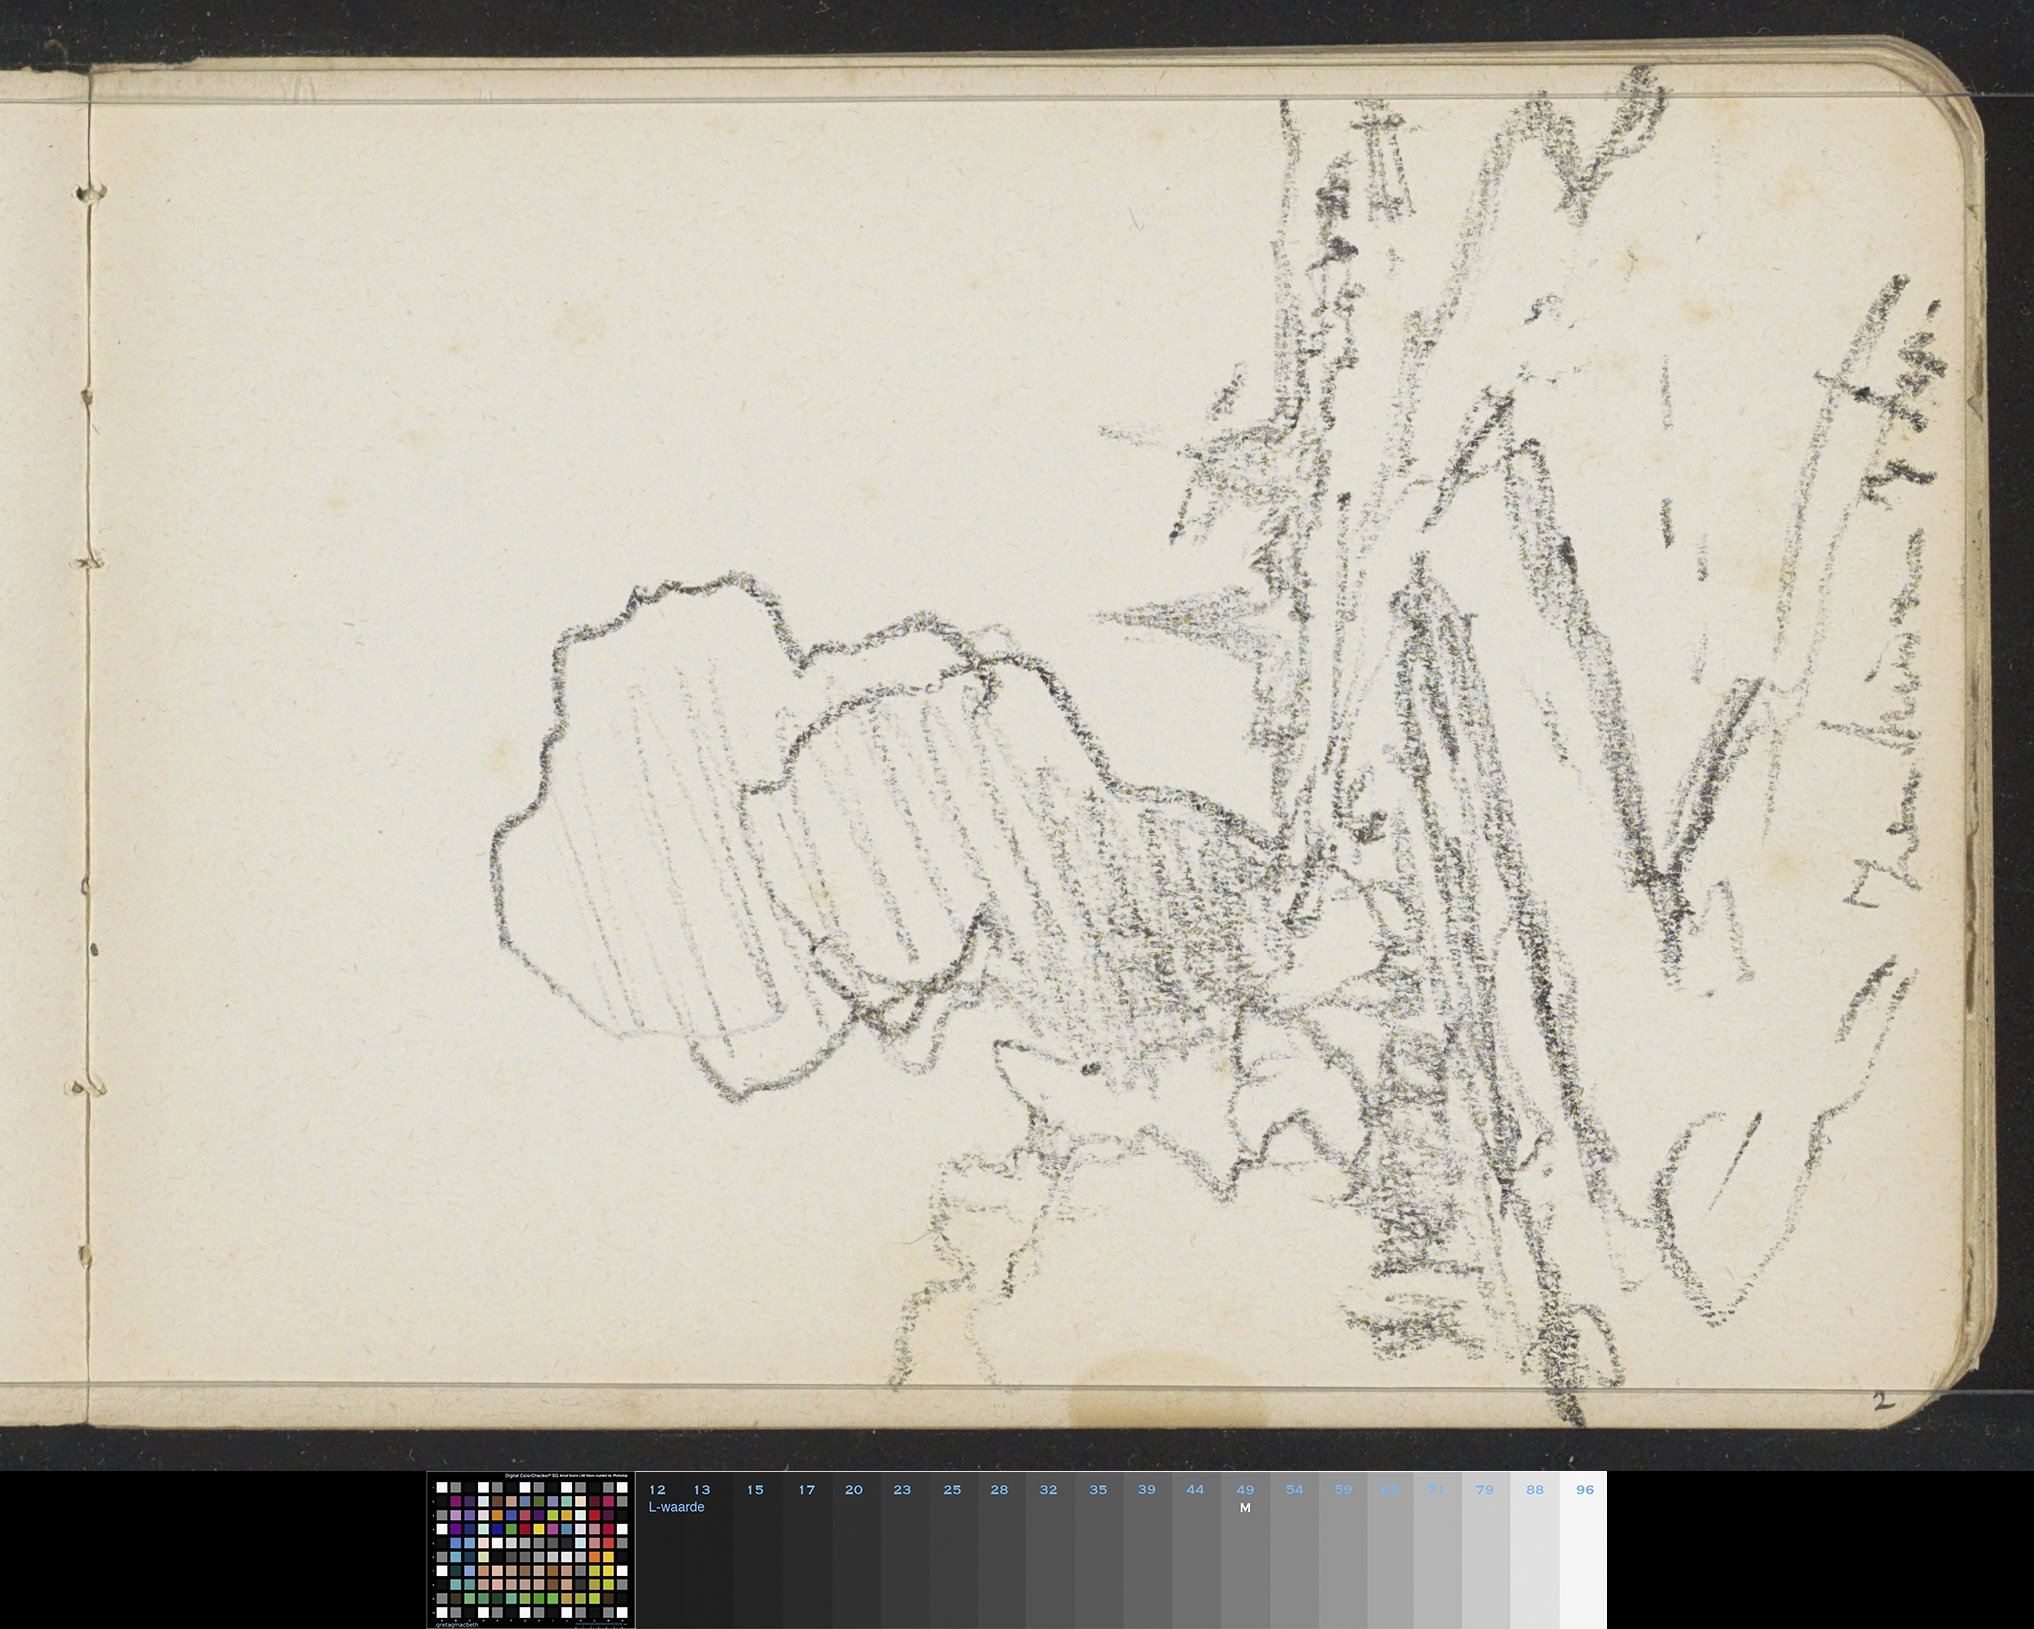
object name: sketchbook leaf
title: Pad richting Zevenhuizen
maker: willem cornelis rip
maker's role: draughtsman, painter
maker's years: 1856-1922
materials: chalk, paper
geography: zevenhuizen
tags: village, windmill in landscape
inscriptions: date and inscription: ‘Zevenhuizen 7 Sep.’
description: Op de achtergrond een molen en kerktoren. Blad 2 recto uit een schetsboek met 44 bladen.